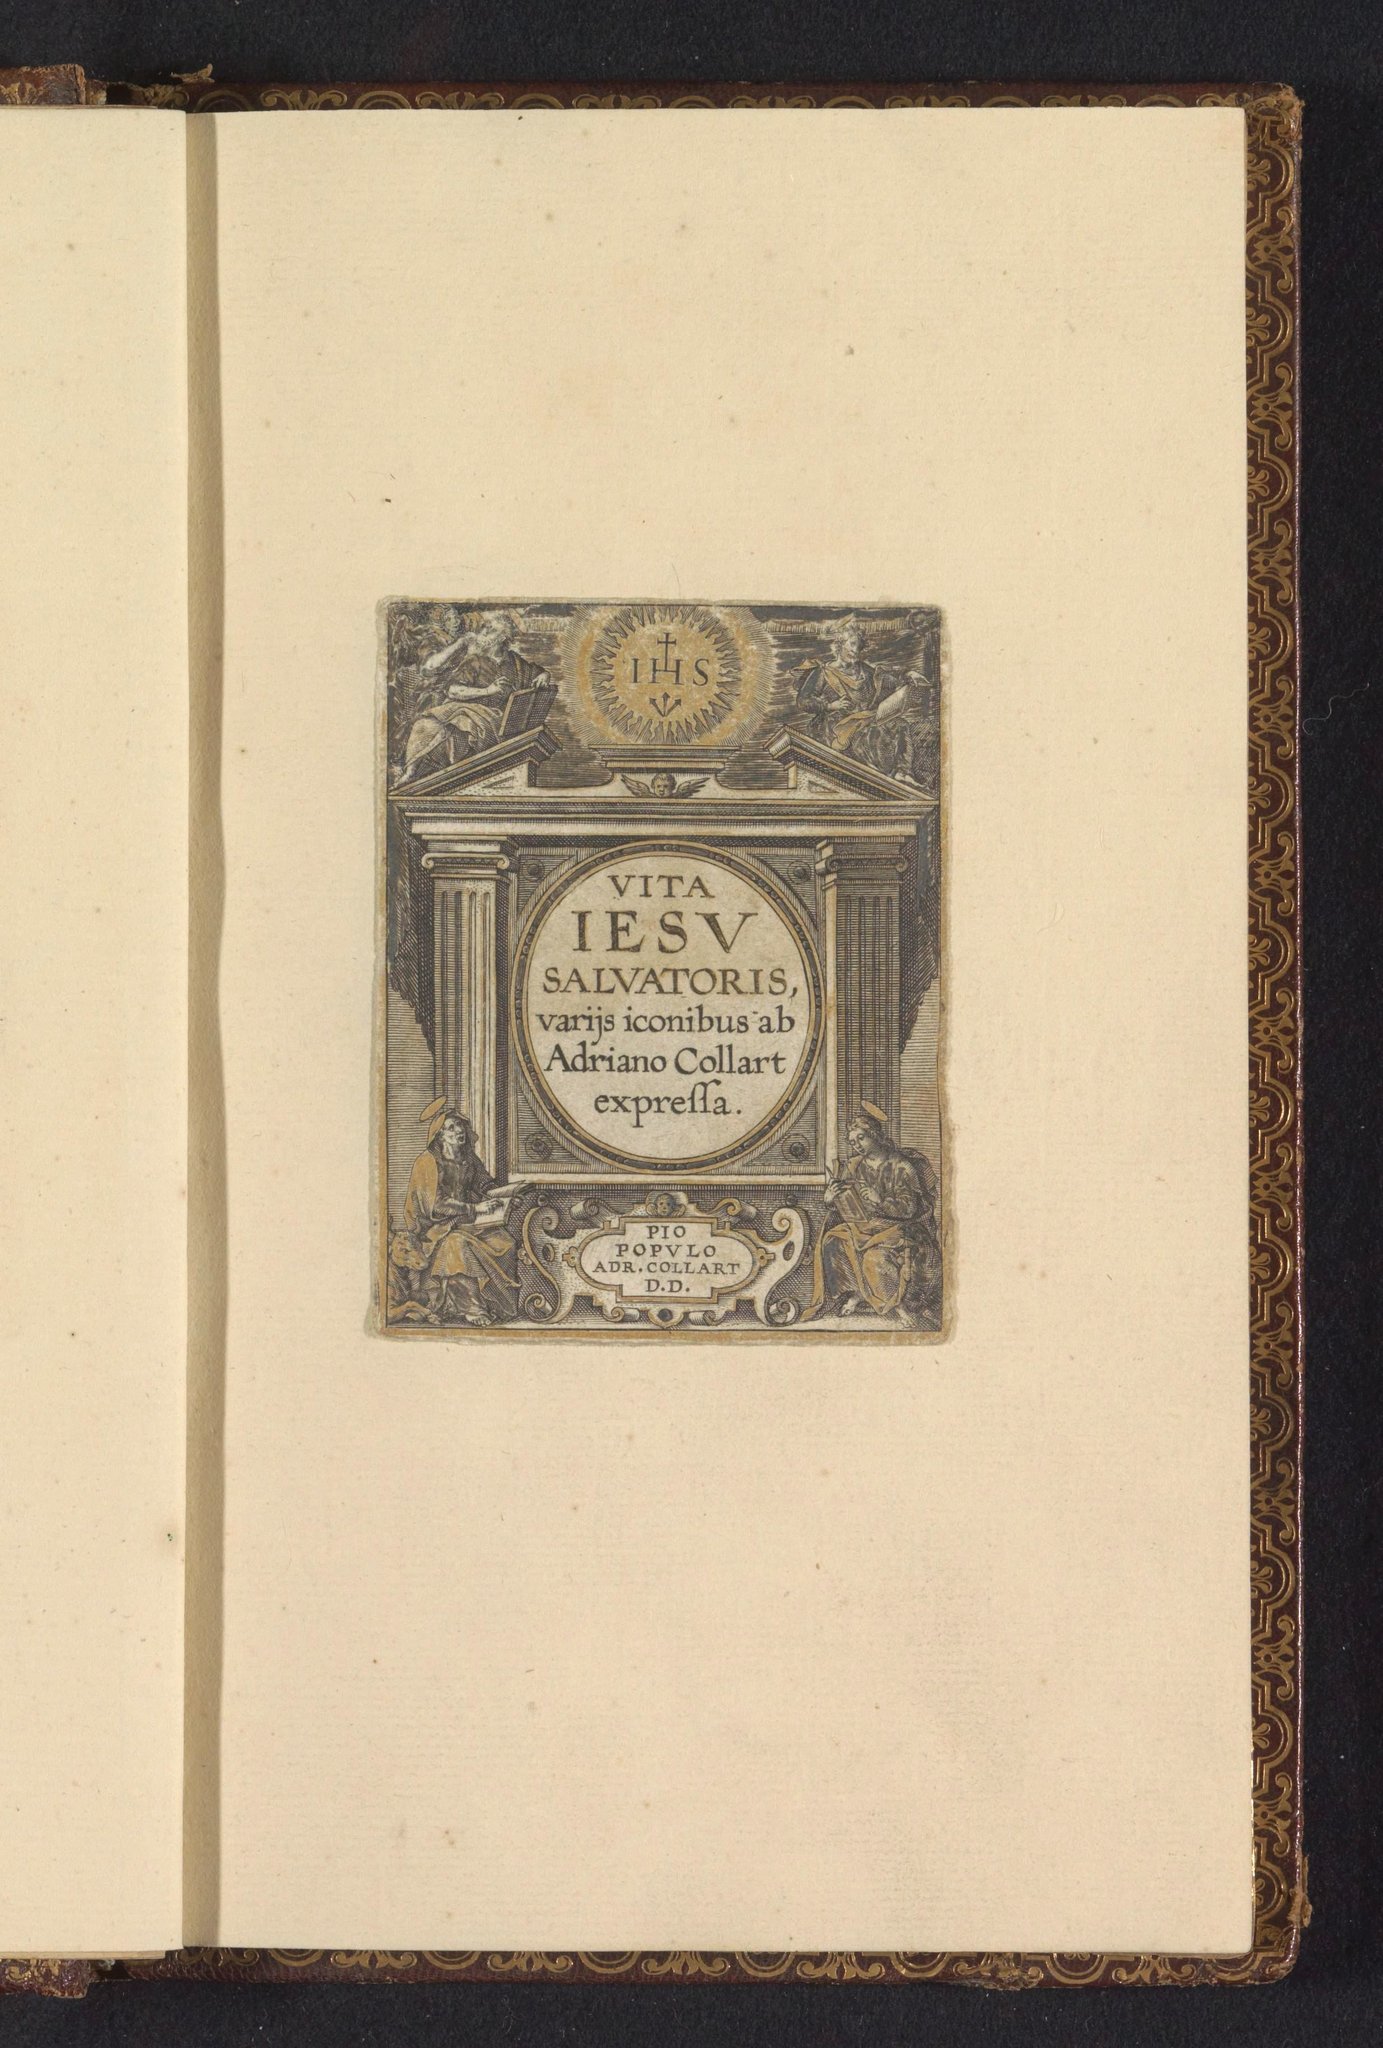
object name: print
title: Vita Iesu Salvatoris varijs iconibus ab Adriano Collaert expressa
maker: adriaen collaert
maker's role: draughtsman, print maker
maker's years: 1560-1618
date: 1580-1590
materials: gold, paper, silver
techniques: engraving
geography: antwerp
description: De gravures van beide reeksen zijn door dezelfde hand gehoogd met goud en zilver. De eerste reeks van 34 (van 35) gravures is een verkleinde versie naar prenten uit een reeks naar Maarten de Vos (nrs. 2-28, 31-33) met toevoeging van drie scènes uit de Wonderen van Christus (nrs. 26, 28, 30).